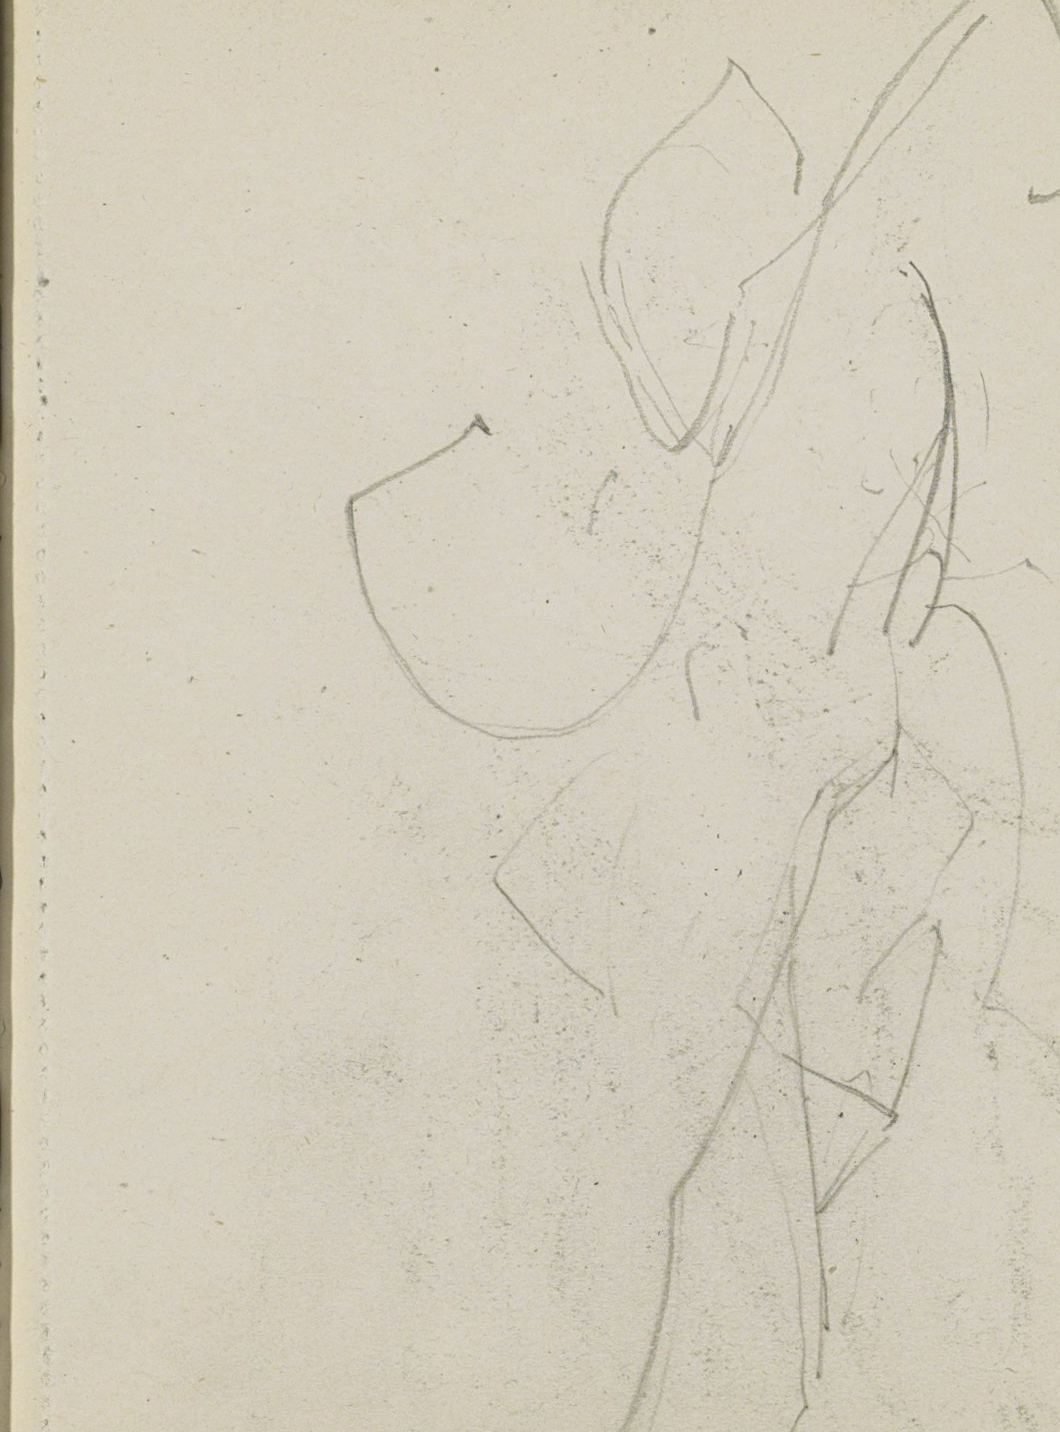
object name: sketchbook leaf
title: Danser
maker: reijer stolk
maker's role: draughtsman, print maker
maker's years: 1896-1945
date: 1906-1945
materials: paper, pencil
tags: one person dancing alone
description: Blad 17 recto uit een schetsboek met 53 bladen.